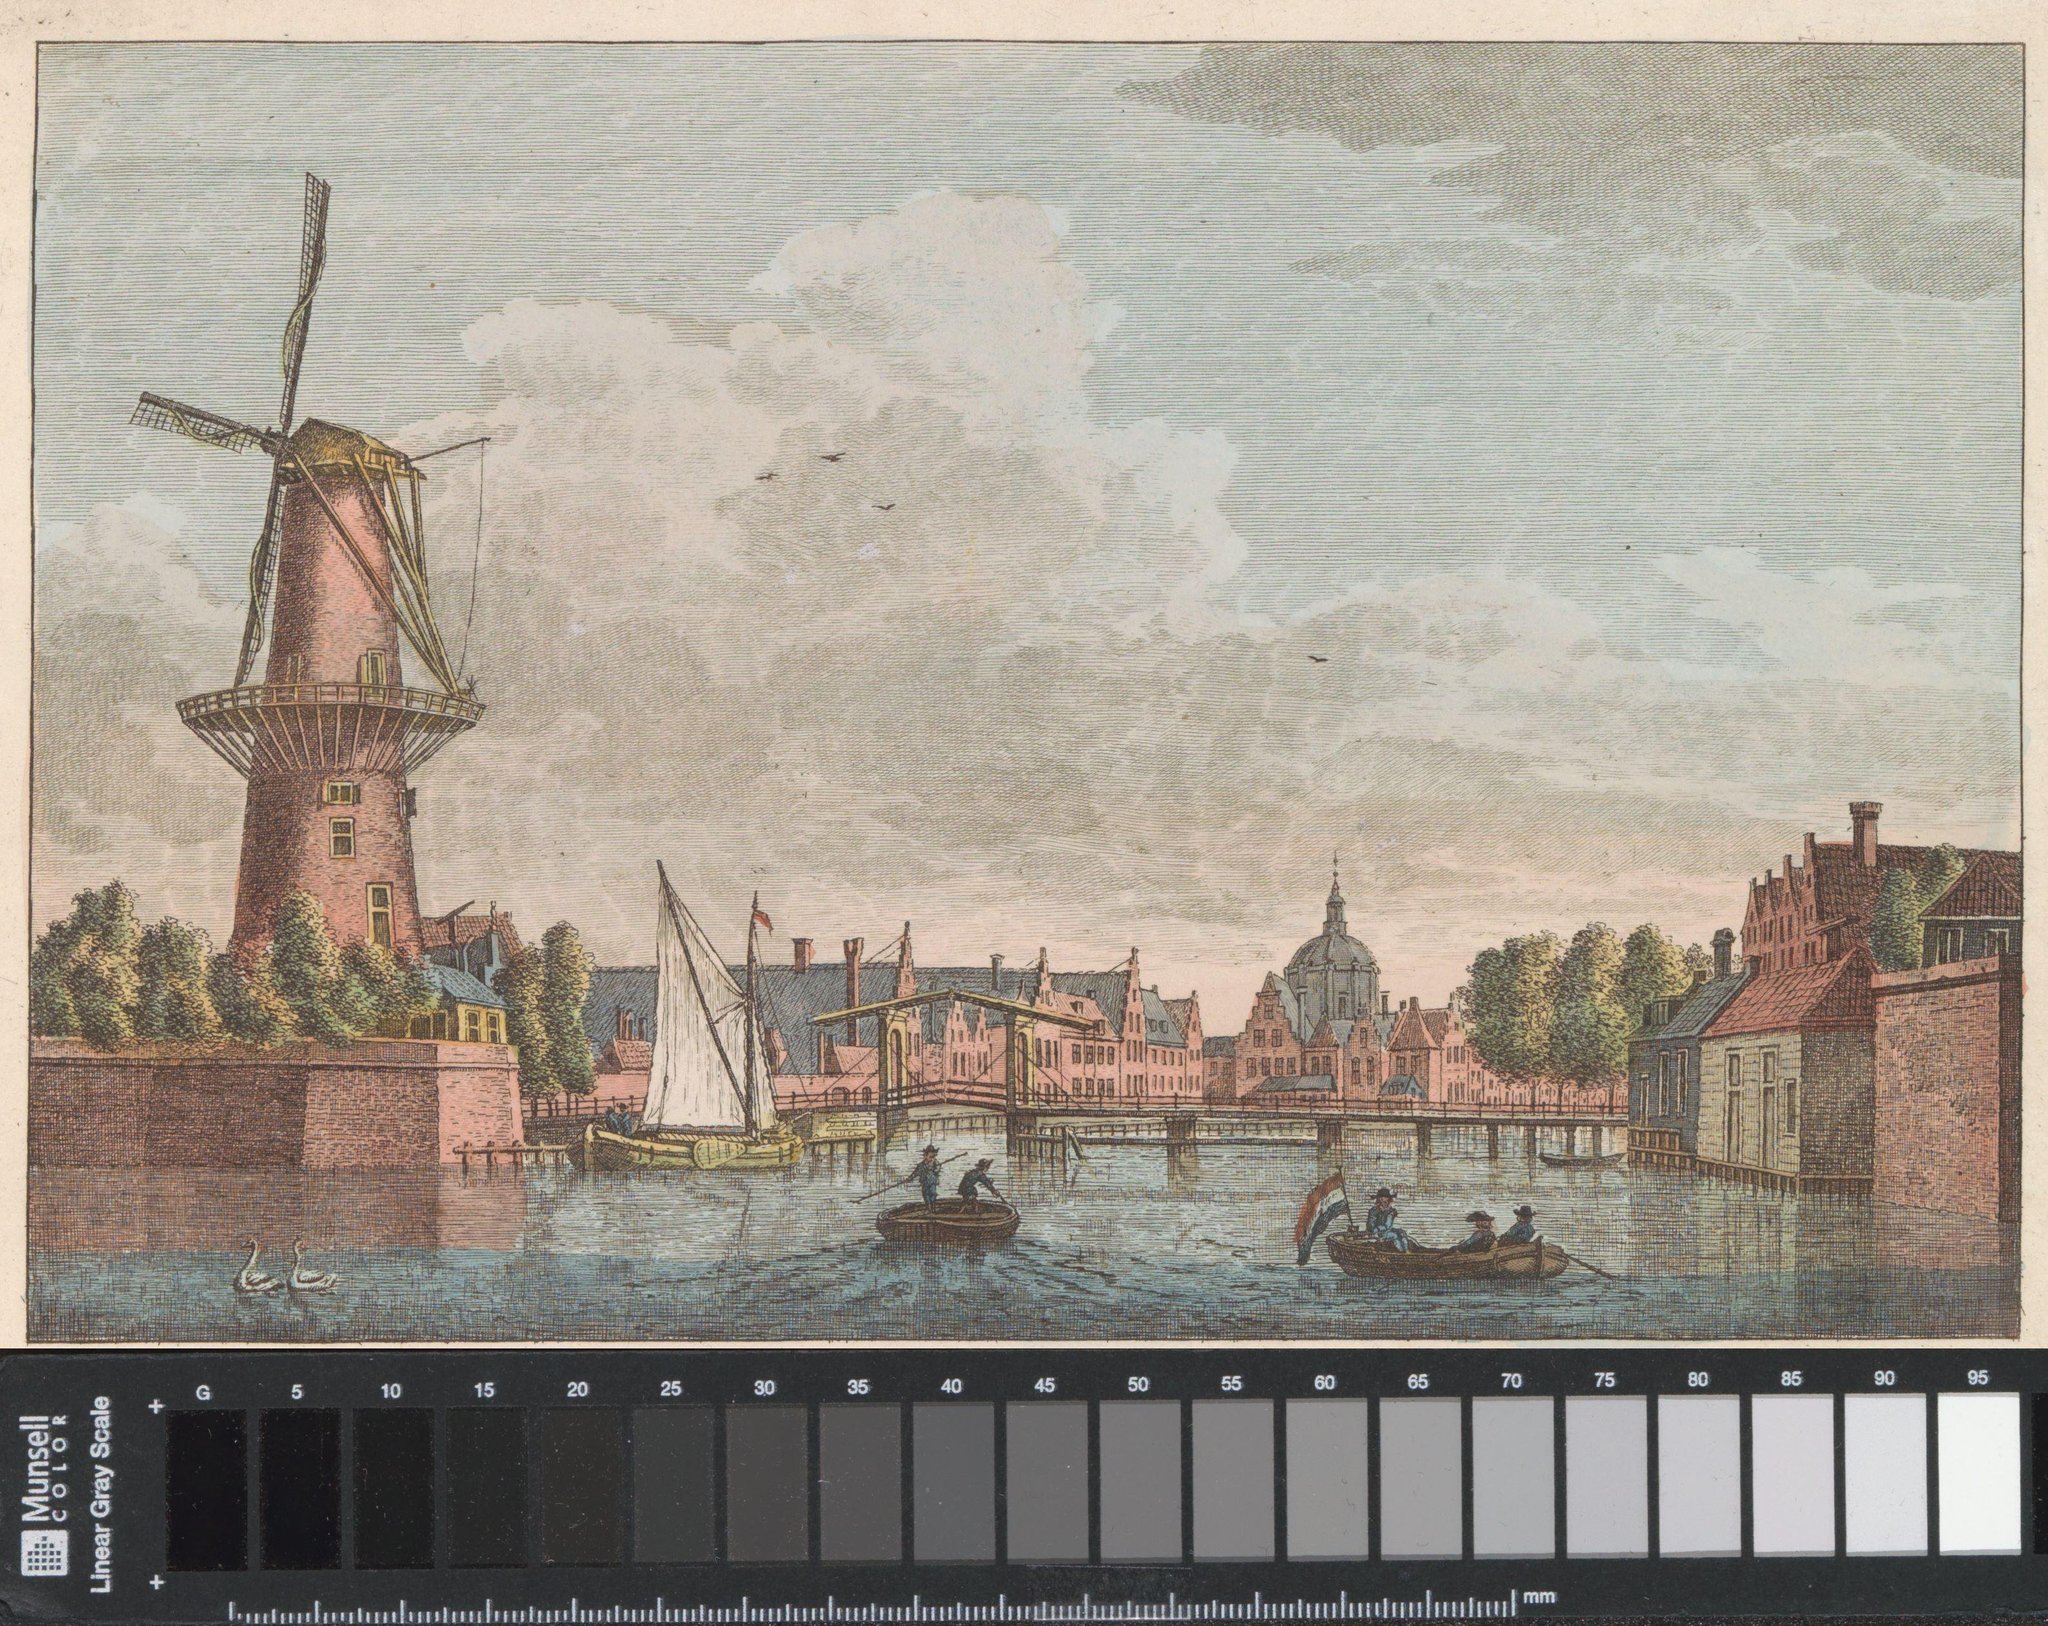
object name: print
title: Het Galgenwater te Leyden / Canal connu sous le nom de Galgewater à Leyden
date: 1786-1792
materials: paper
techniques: engraving, etching, hand coloring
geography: amsterdam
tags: windmill, leiden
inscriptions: inscription: ‘chez E: Maaskamp à Amsterdam’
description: Huidige staat van prent uitgegeven als onderdeel van een plaatwerk uit ca. 1824-1825 met 74 (ongenummerde) platen van de belangrijkste topografische gezichten en verschillende zeden en gewoonten in het Verenigd Koninkrijk der Nederlanden, getiteld 'Tableau des principales vues des palais et édifices : représentations et des coutumes et usages, dans les provinces septentrionales du Royaume des Pays-Bas'. Eerdere staat gebruikt in: Vaderlandsche gezichten, of afbeeldingen van den tegenwoordigen staat der Vereenigde Nederlanden (…). Amsterdam: Hendrik Gartman, Willem Vermandel en Jan Willem Smit, 1786-1792. Uitgegeven in afleveringen met ieder een eigen bifolium en inhoudsopgave. Alle prenten in deze publicatie zijn gegraveerd door Carel Frederik Bendorp (I) en, in de meeste gevallen, gebaseerd op tekeningen van Jan Bulthuis.